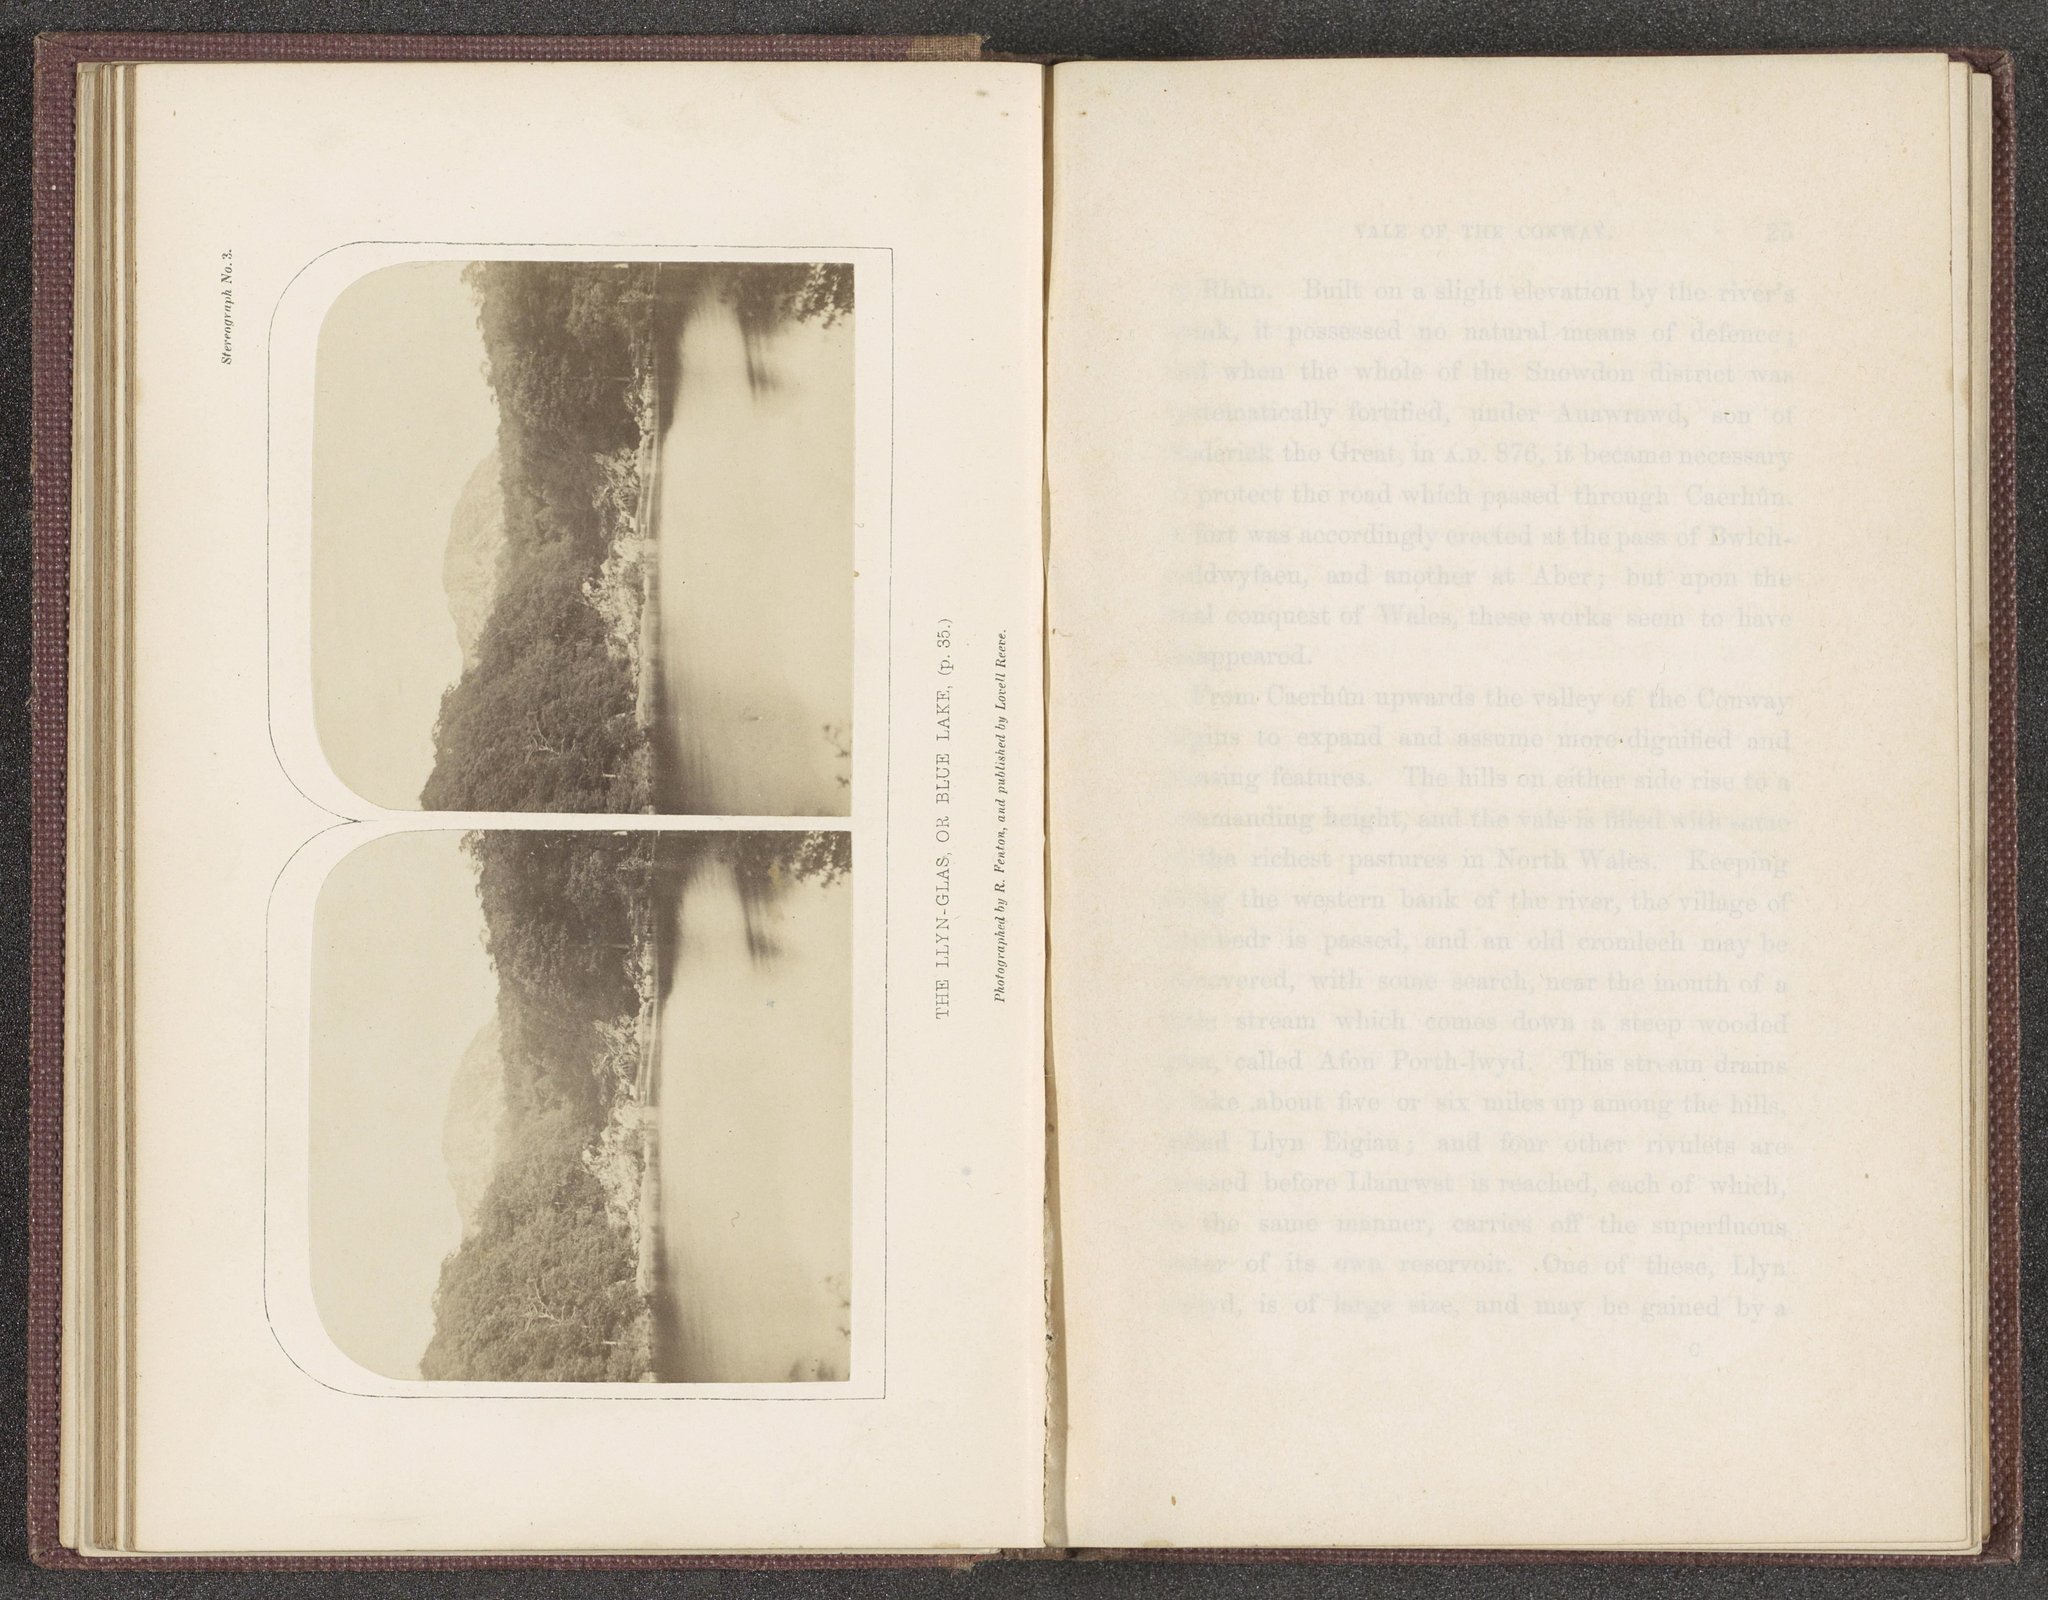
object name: page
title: The Llyn-Glas or blue lake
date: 1859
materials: paper, photographic support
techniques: albumen print, printing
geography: wales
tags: lake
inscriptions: number: ‘Stereograph No. 3.’